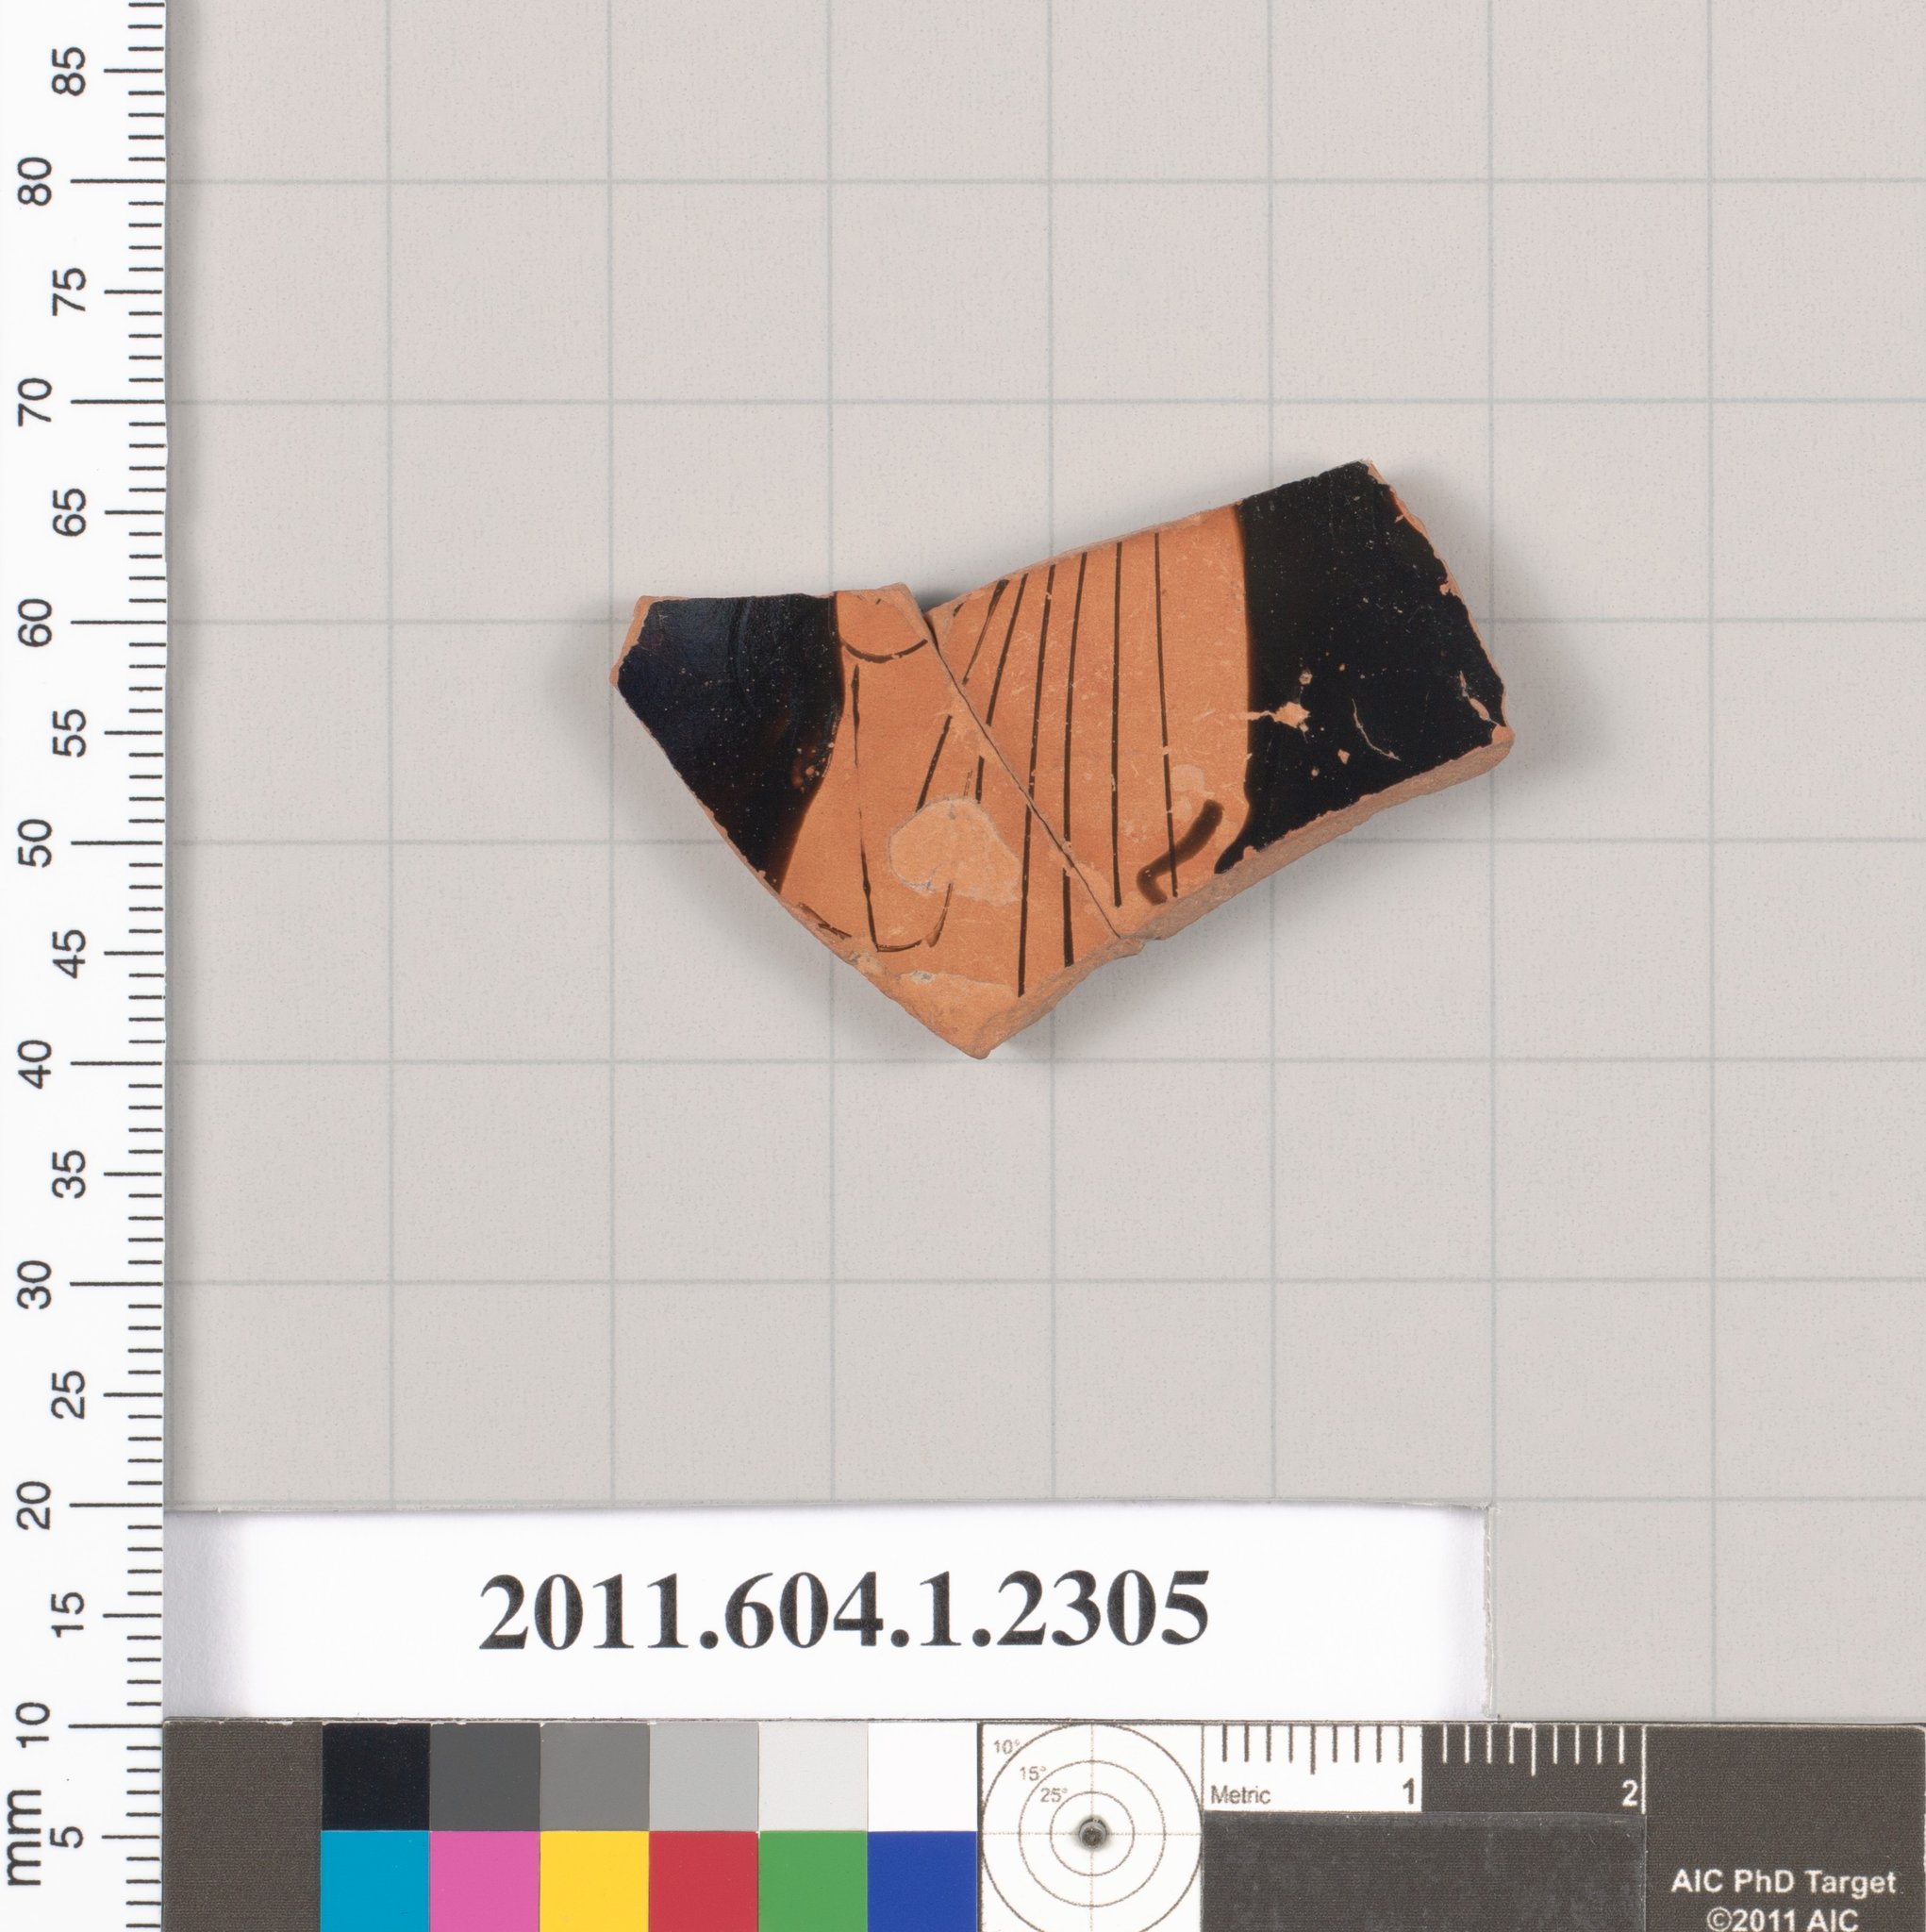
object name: kylix fragment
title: Terracotta fragment of a kylix (drinking cup)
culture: greek, attic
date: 475-451 BCE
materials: terracotta